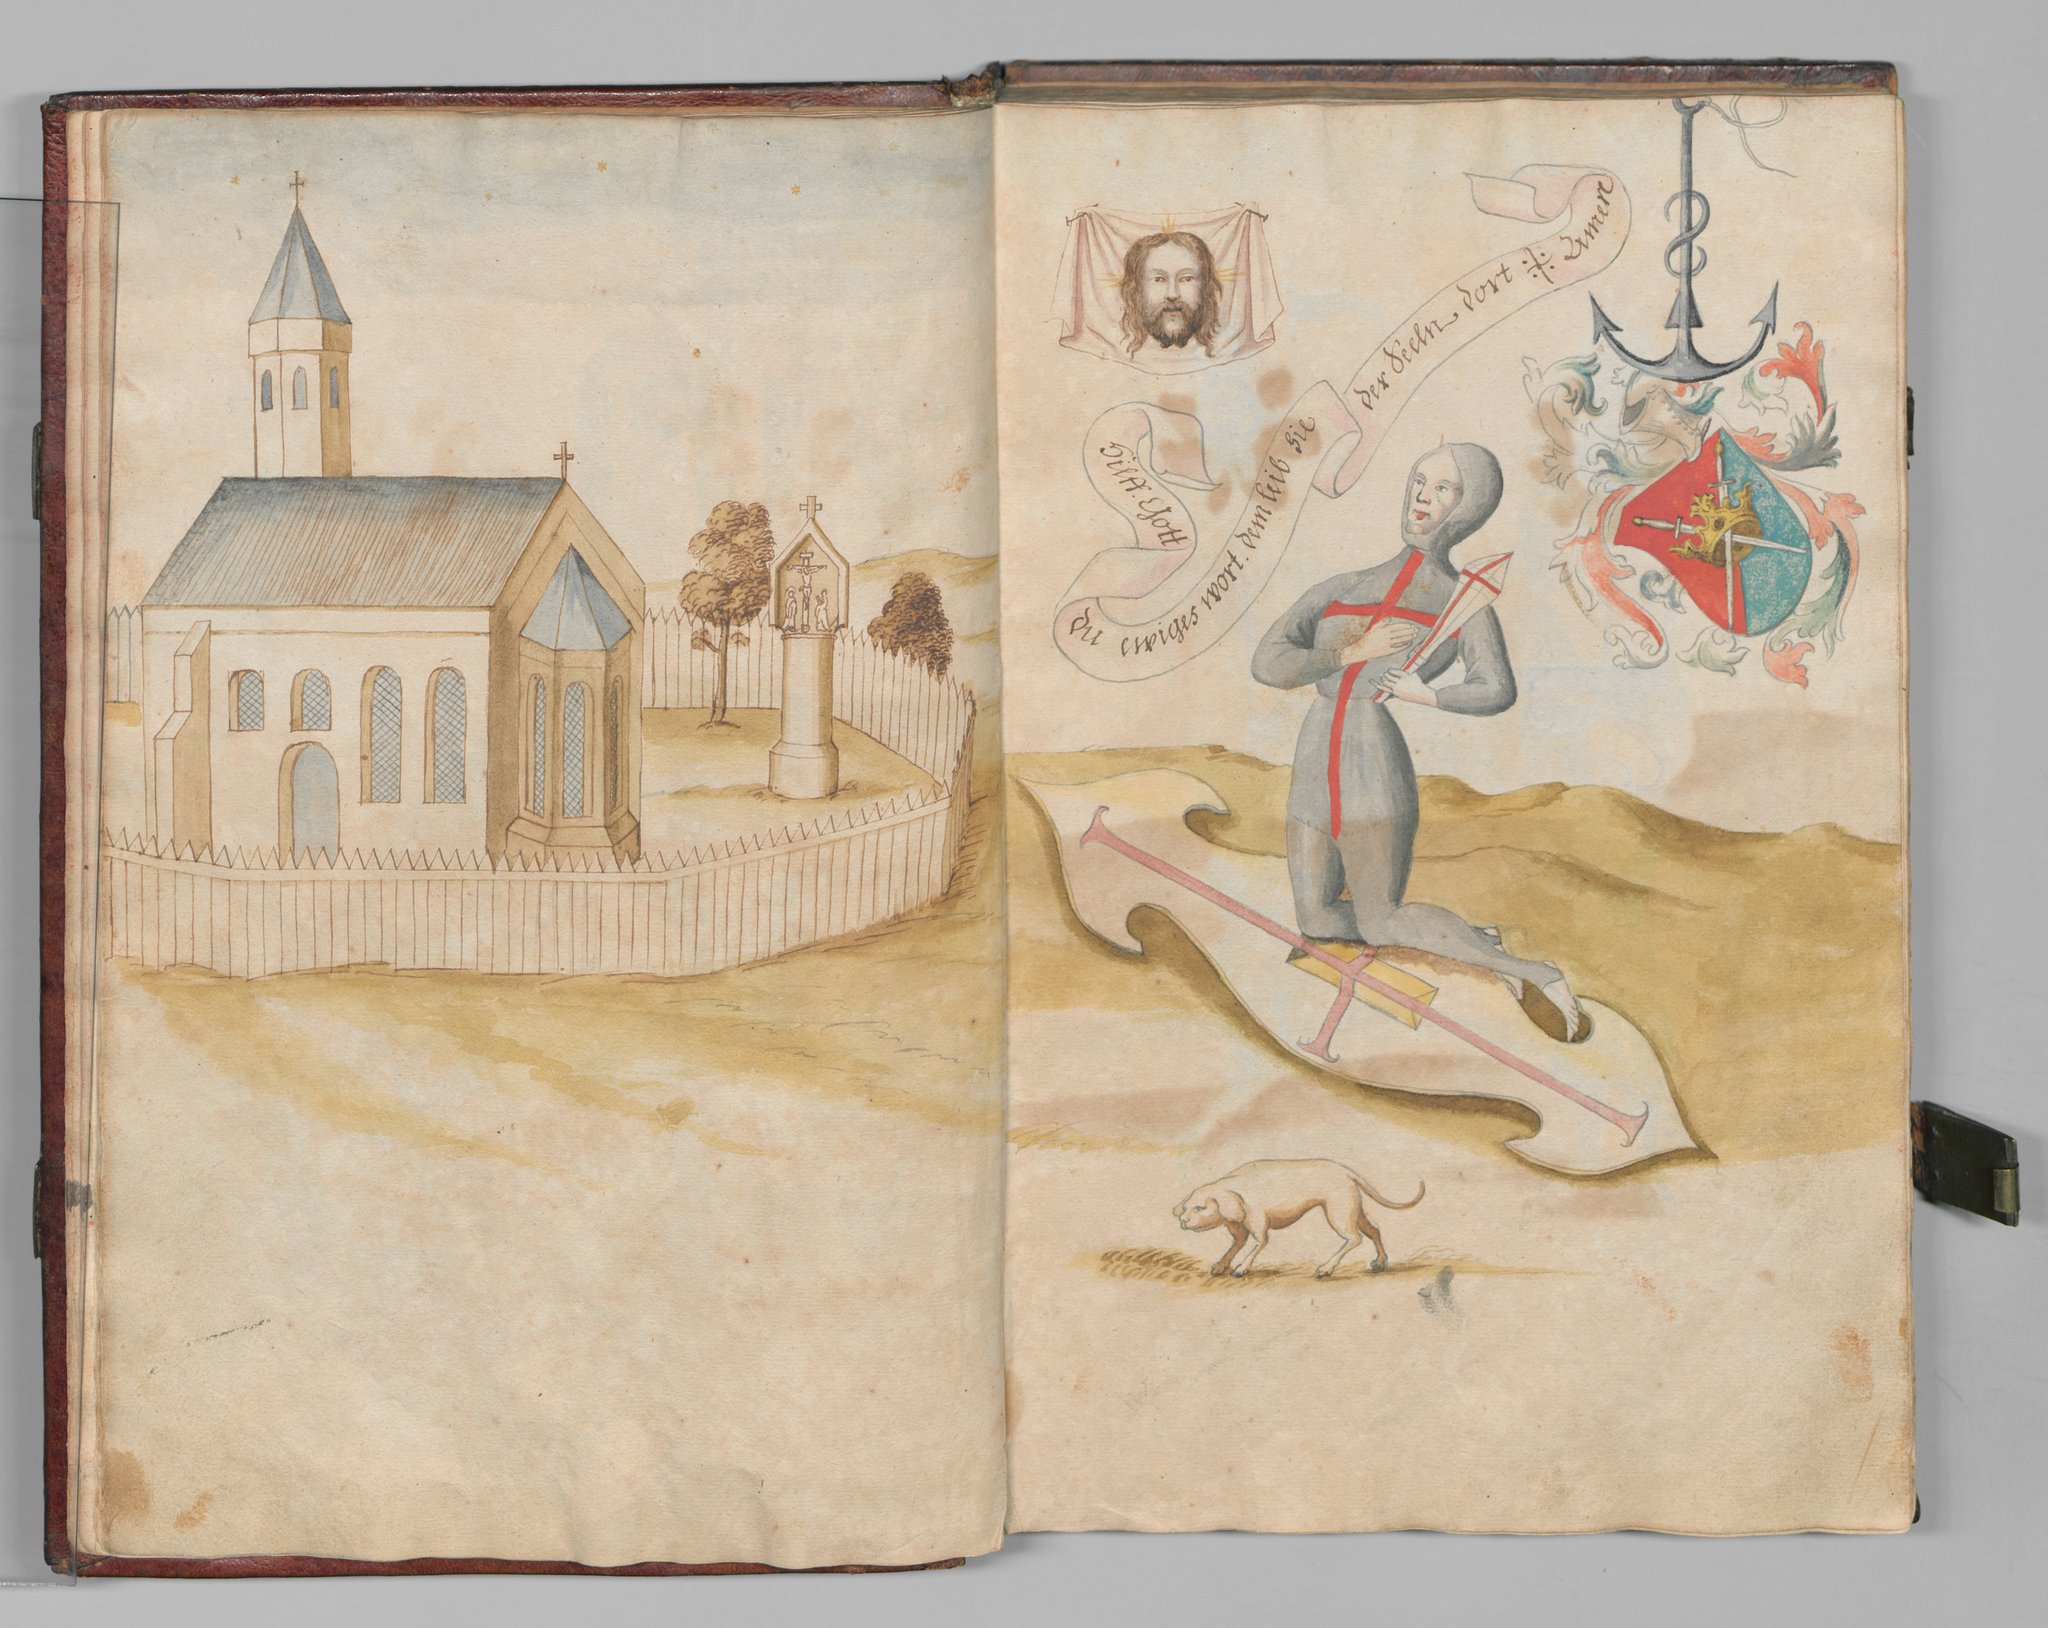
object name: book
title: Fencing Book (Fechtbuch)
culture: german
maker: hans talhoffer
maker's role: author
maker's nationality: german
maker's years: 1435-1482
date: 1501-1600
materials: brass, leather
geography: germany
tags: fencing